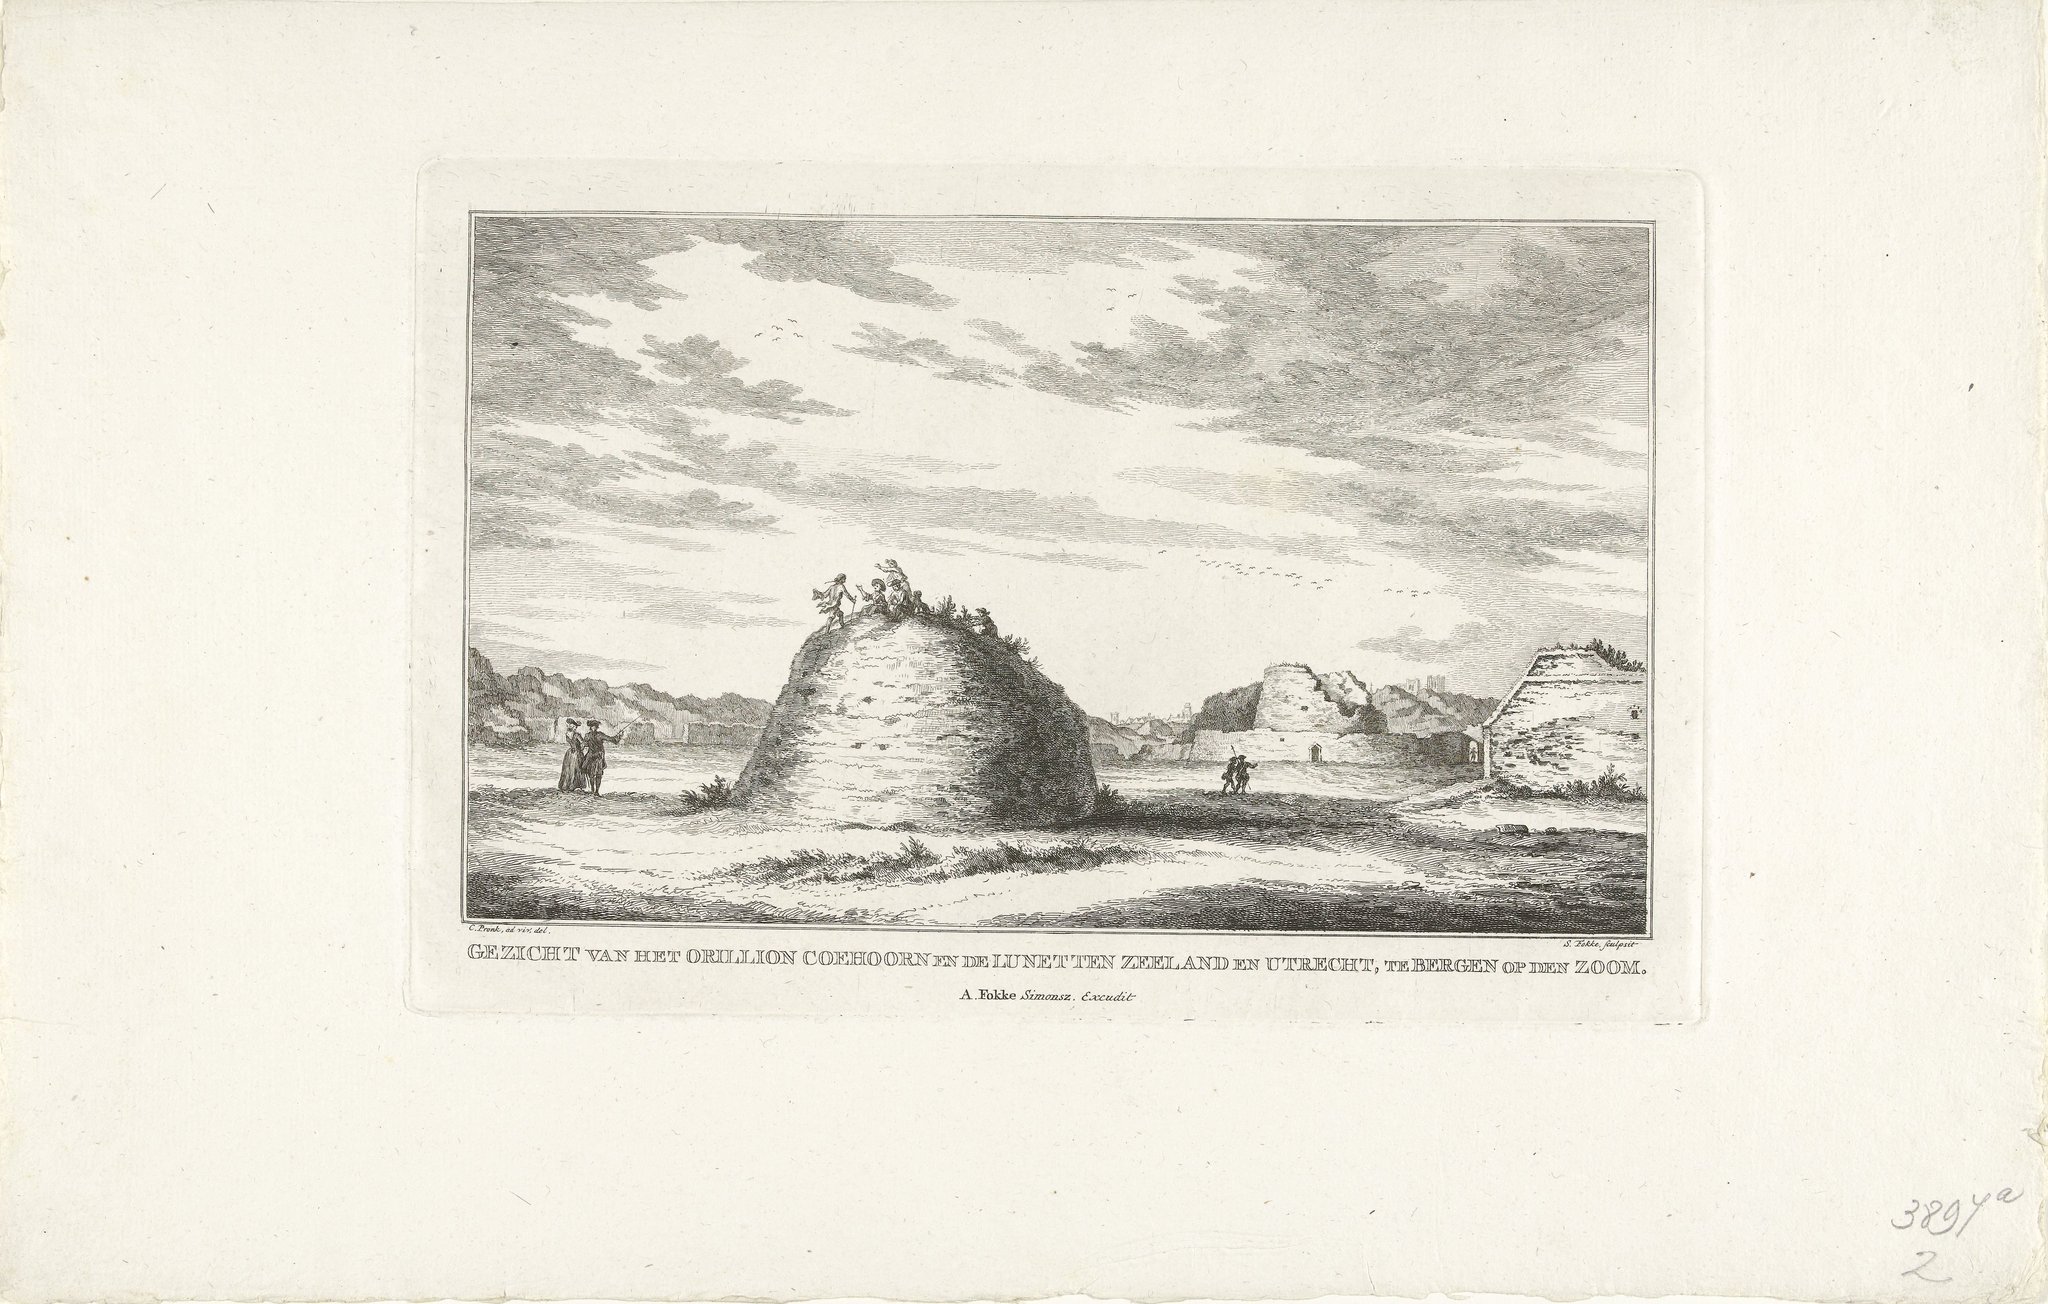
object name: print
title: Ruïnes van de orillon Coehoorn en de lunetten Zeeland en Utrecht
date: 1772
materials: paper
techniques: etching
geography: northern netherlands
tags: fortress, landscape with ruins, bergen op zoom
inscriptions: collector's mark: Lugt 2228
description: Muller geeft aan dat de prenten door Simon Fokke in 1772 naar de tekeningen van Pronk uit 1748 zijn vervaardigd. In de Collecties Thuis in Brabant (collecties in Brabantse musea en archieven) is een ontwerptekening (met inv.nr.: BC-Tha oai:tha.uvt.nl:709121) voor een prent in de serie bewaard met de annotatie: Hoogstraat. na t Leven geschest (sic) door C.Pronk 1748. opgetekent door S. Fokke 1772.